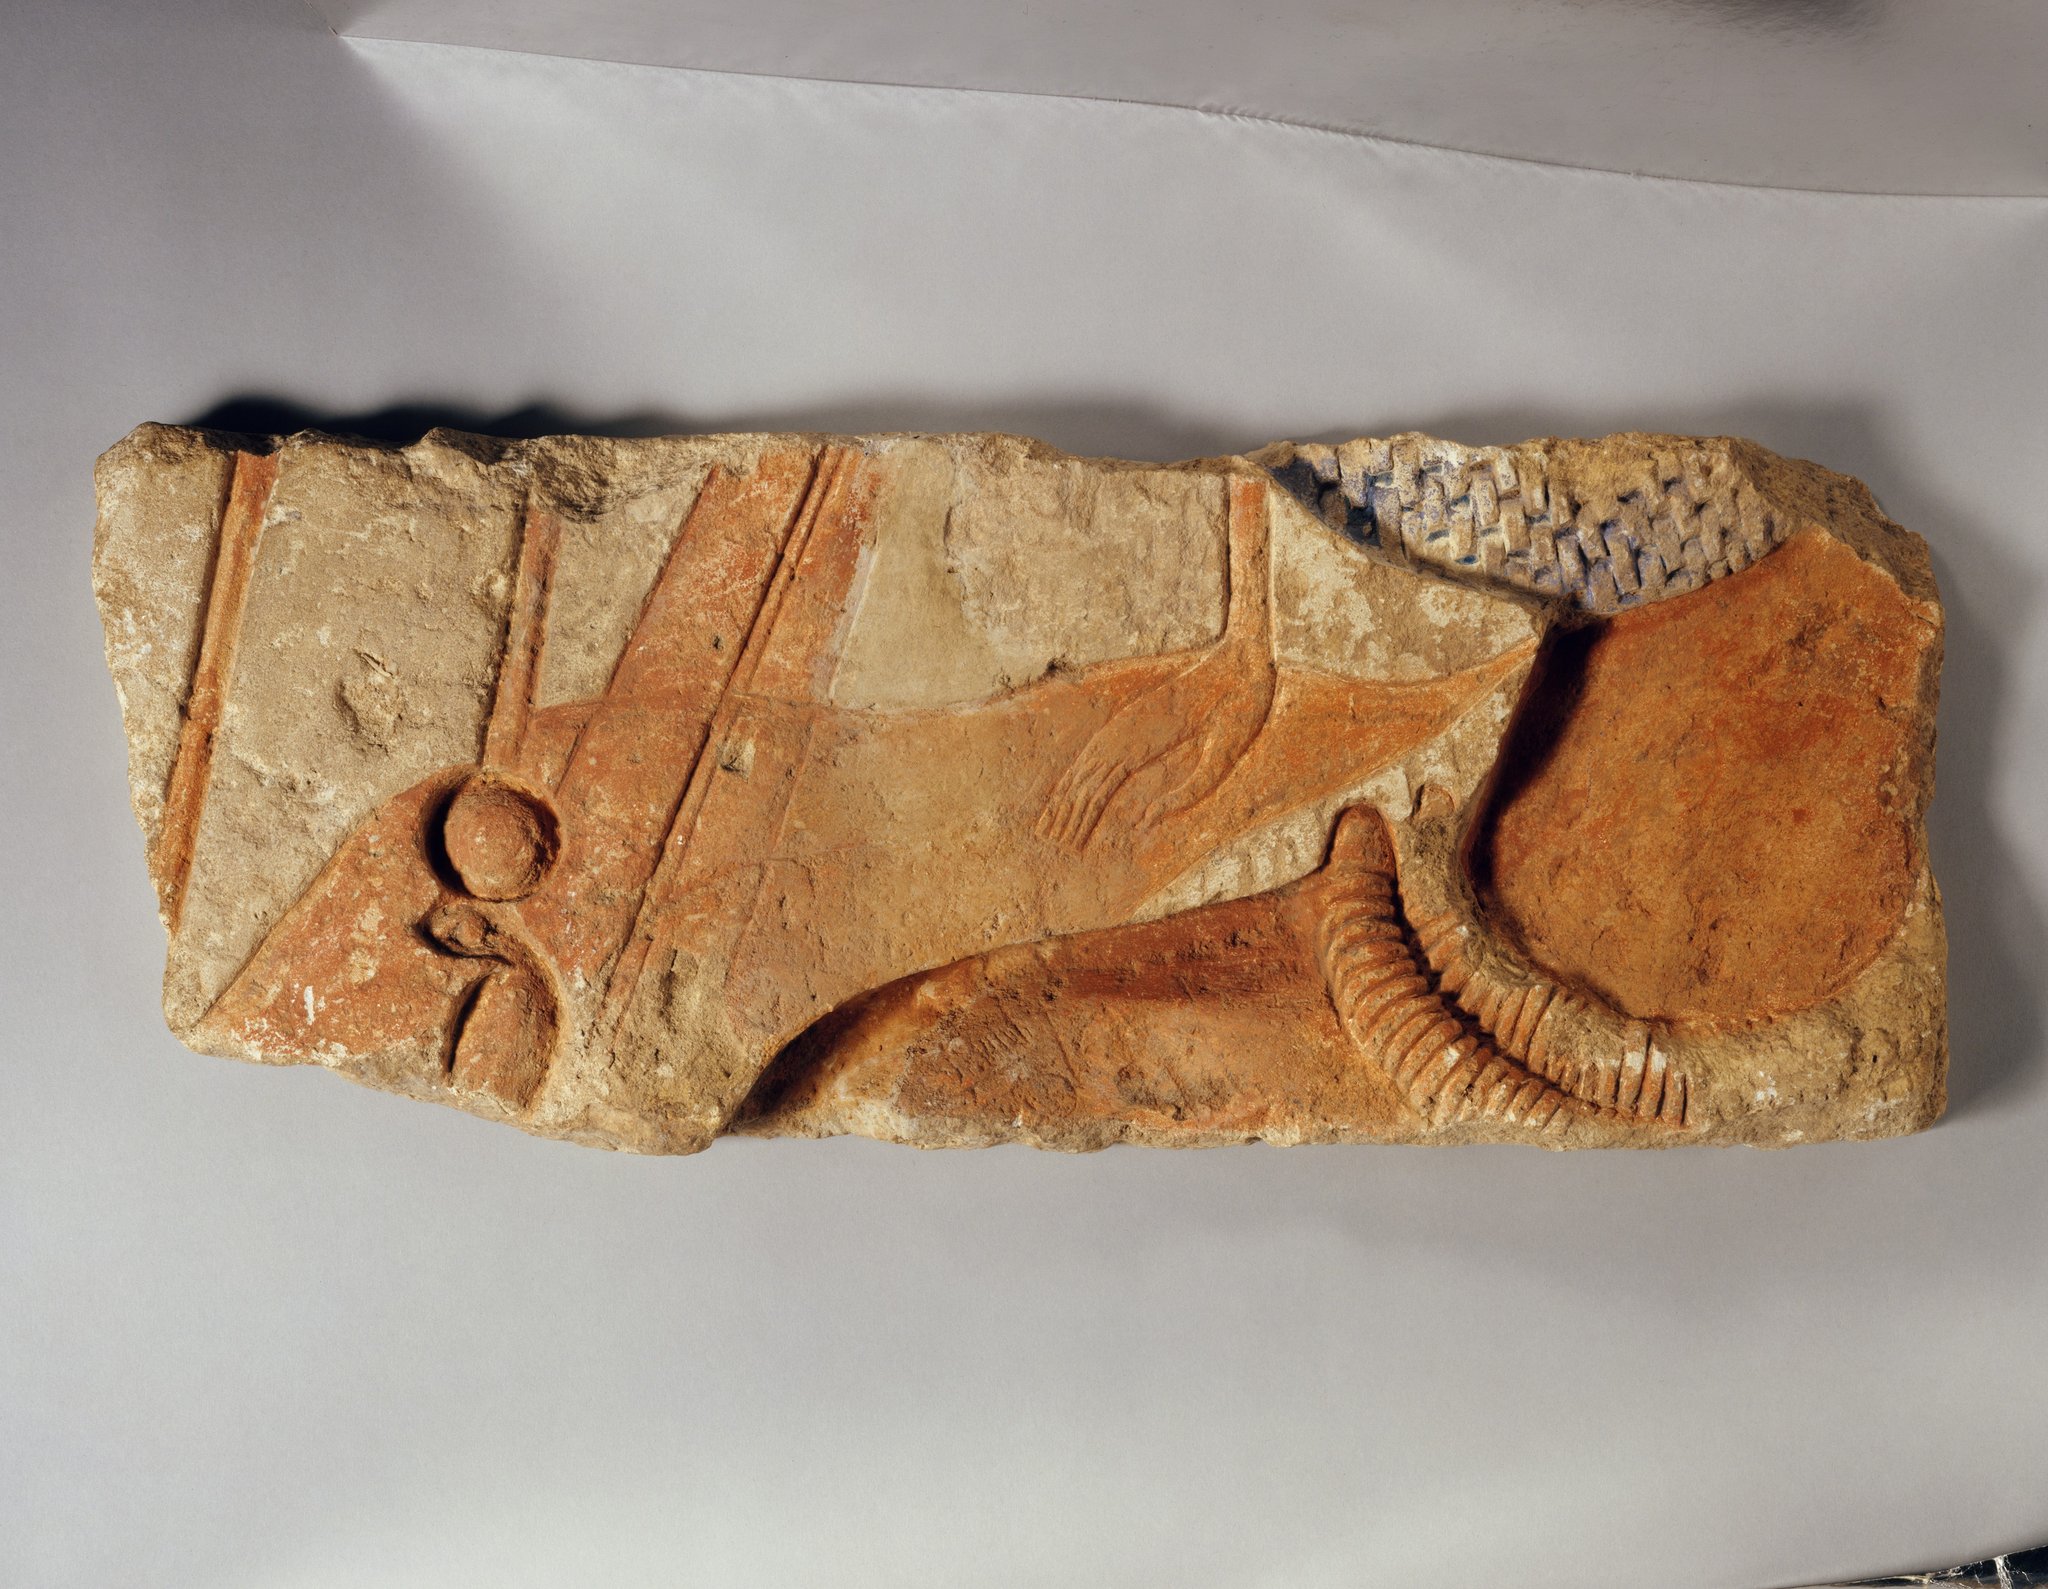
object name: talatat, royal male wearing gold of honor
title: Relief with royal male wearing gold of honor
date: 1353-1336 BCE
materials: limestone, paint